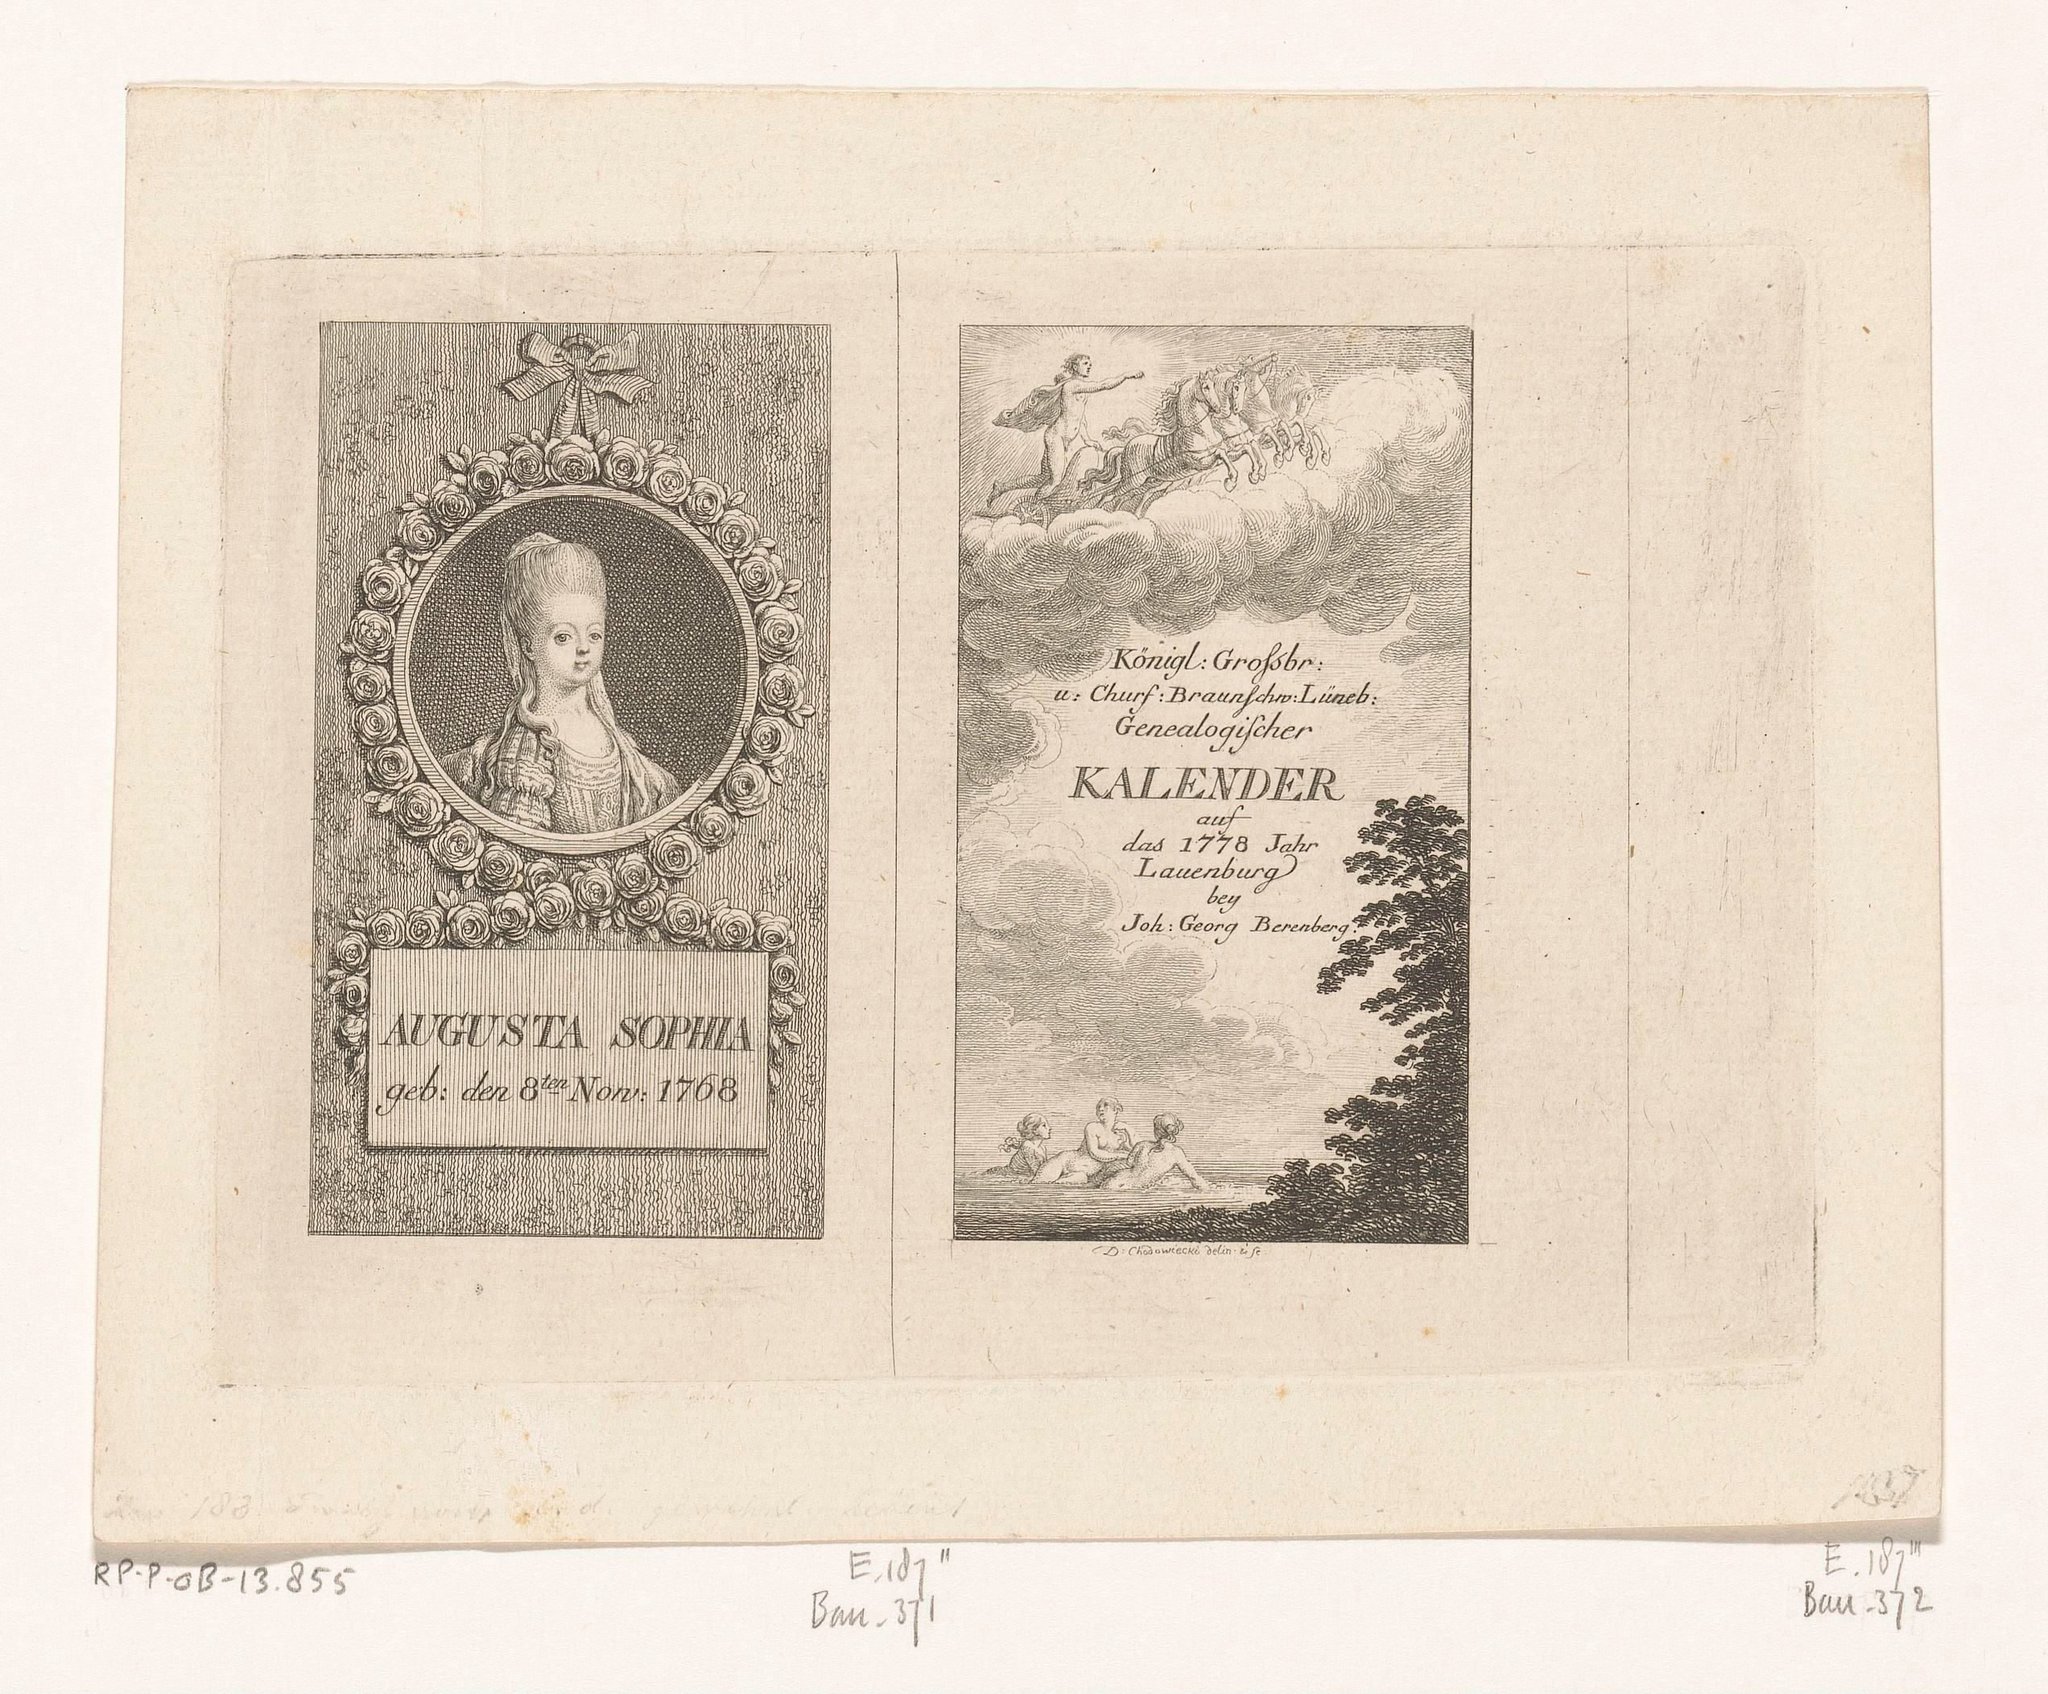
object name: print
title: Portret van Augusta Sophia en Apollo in de zonnewagen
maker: daniel nikolaus chodowiecki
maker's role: draughtsman, print maker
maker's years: 1726-1801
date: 1777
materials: paper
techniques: etching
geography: berlin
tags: historical persons - bb - woman, apollo in the chariot of the sun, drawn by four horses, usually preceded by aurora holding a torch; 'carro del sole' (ripa)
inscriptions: collector's mark: Lugt 2228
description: Deze prent is ook gebruikt als titelpagina voor: Königl. Grossbr. u. Churf: Braunschw: Lüneb: Genealogischer Kalender auf das 1778 Jahr. Lauenburg: Johann Georg Bergenberg.